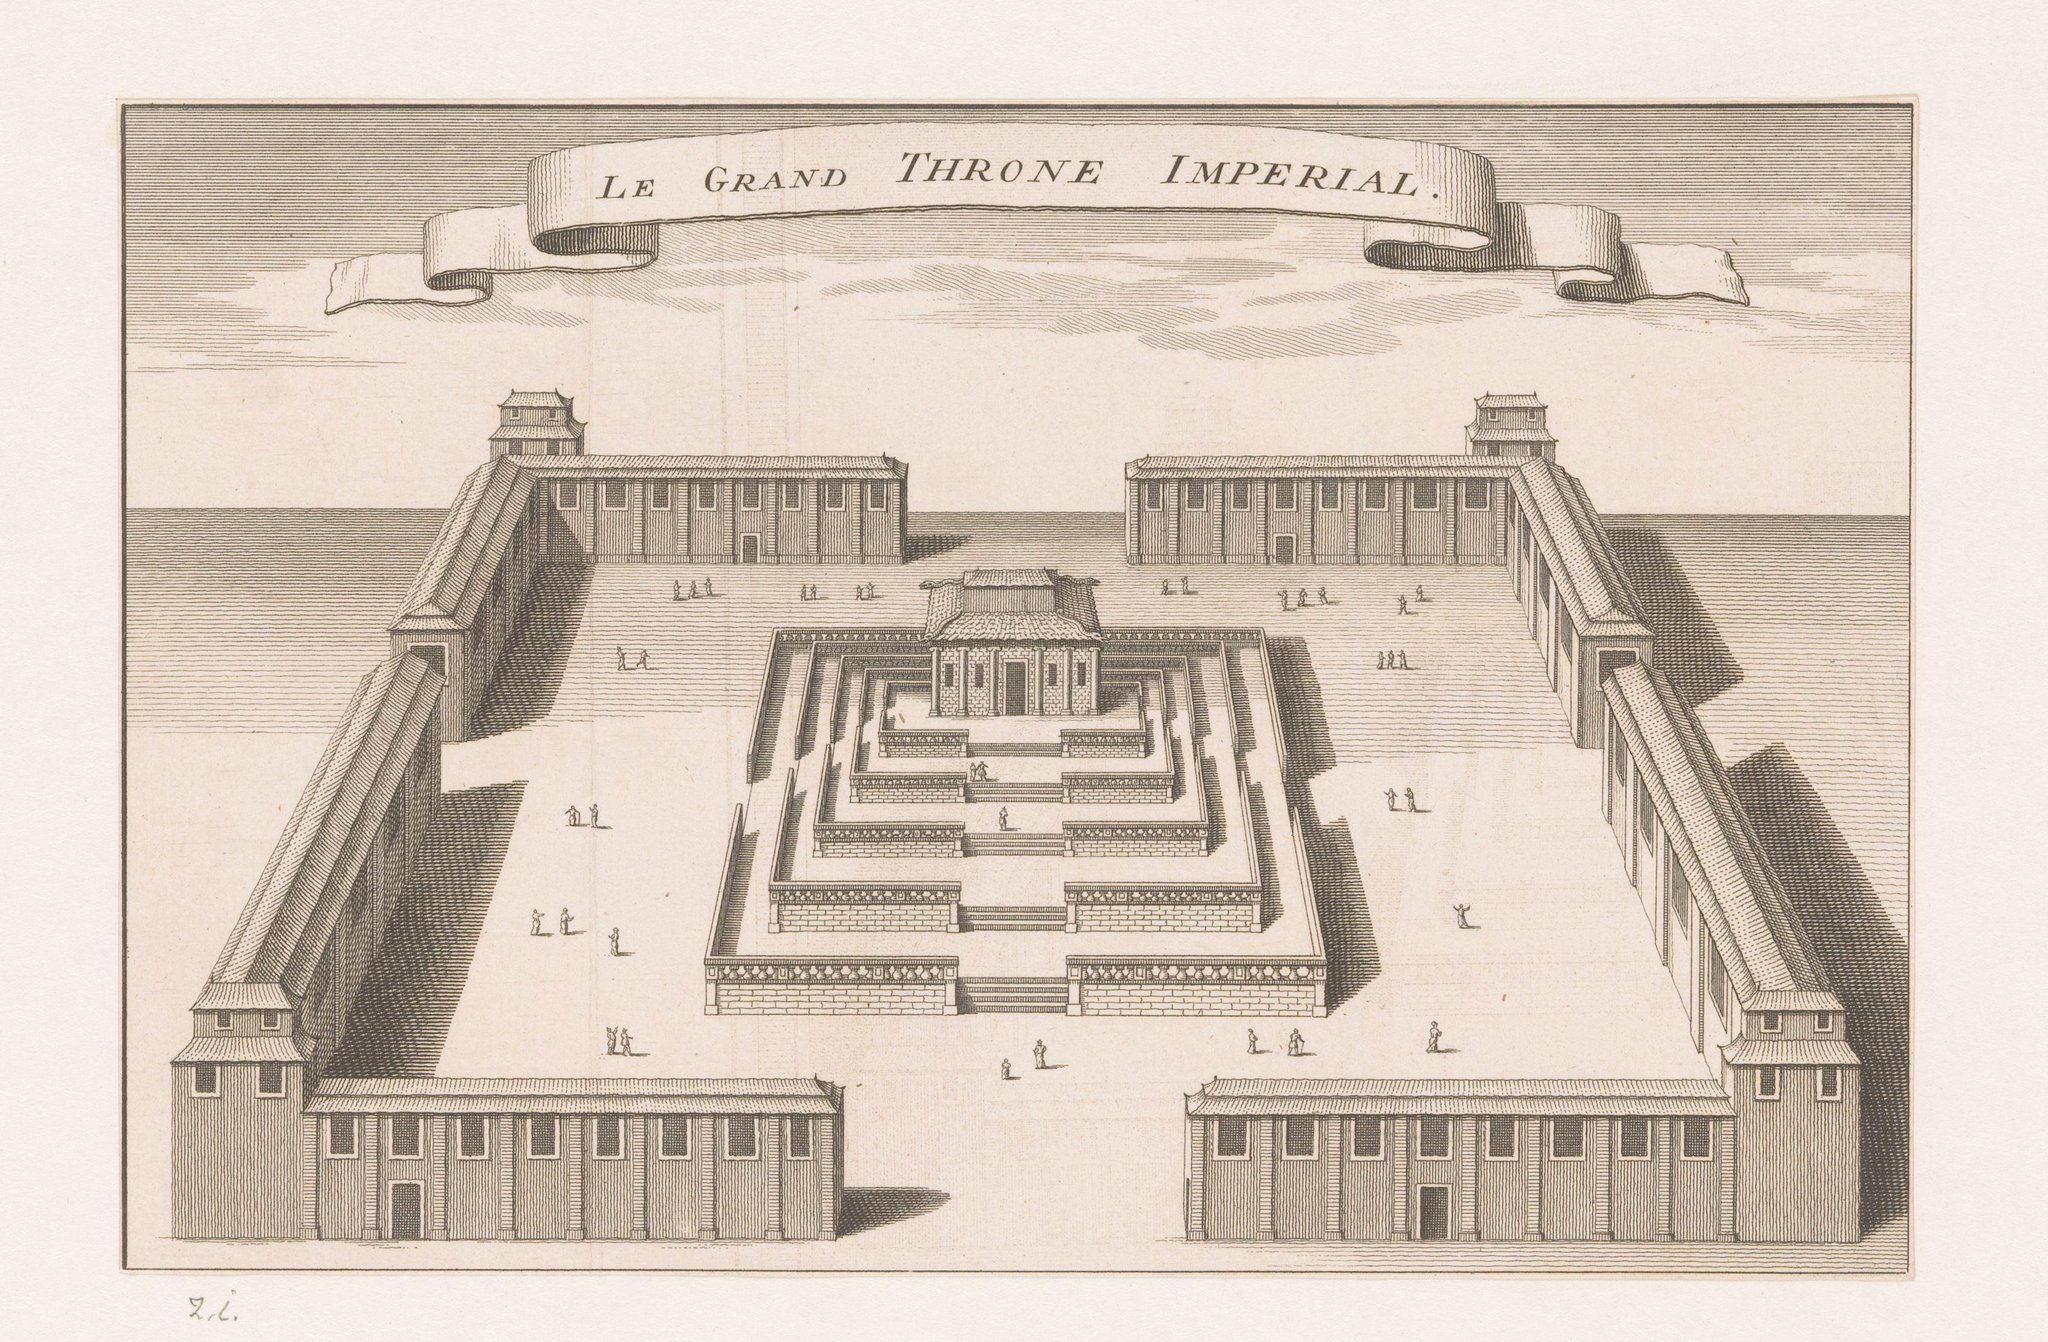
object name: print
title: Gezicht op de Verboden Stad te Peking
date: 1747-1768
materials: paper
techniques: engraving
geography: amsterdam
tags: inner court of palace or 'hôtel'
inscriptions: collector's mark: Lugt 2228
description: Prent uit: Prévost, A.F. Histoire générale des voyages (...). 18 dln. Den Haag: De Hondt, 1747-1768.